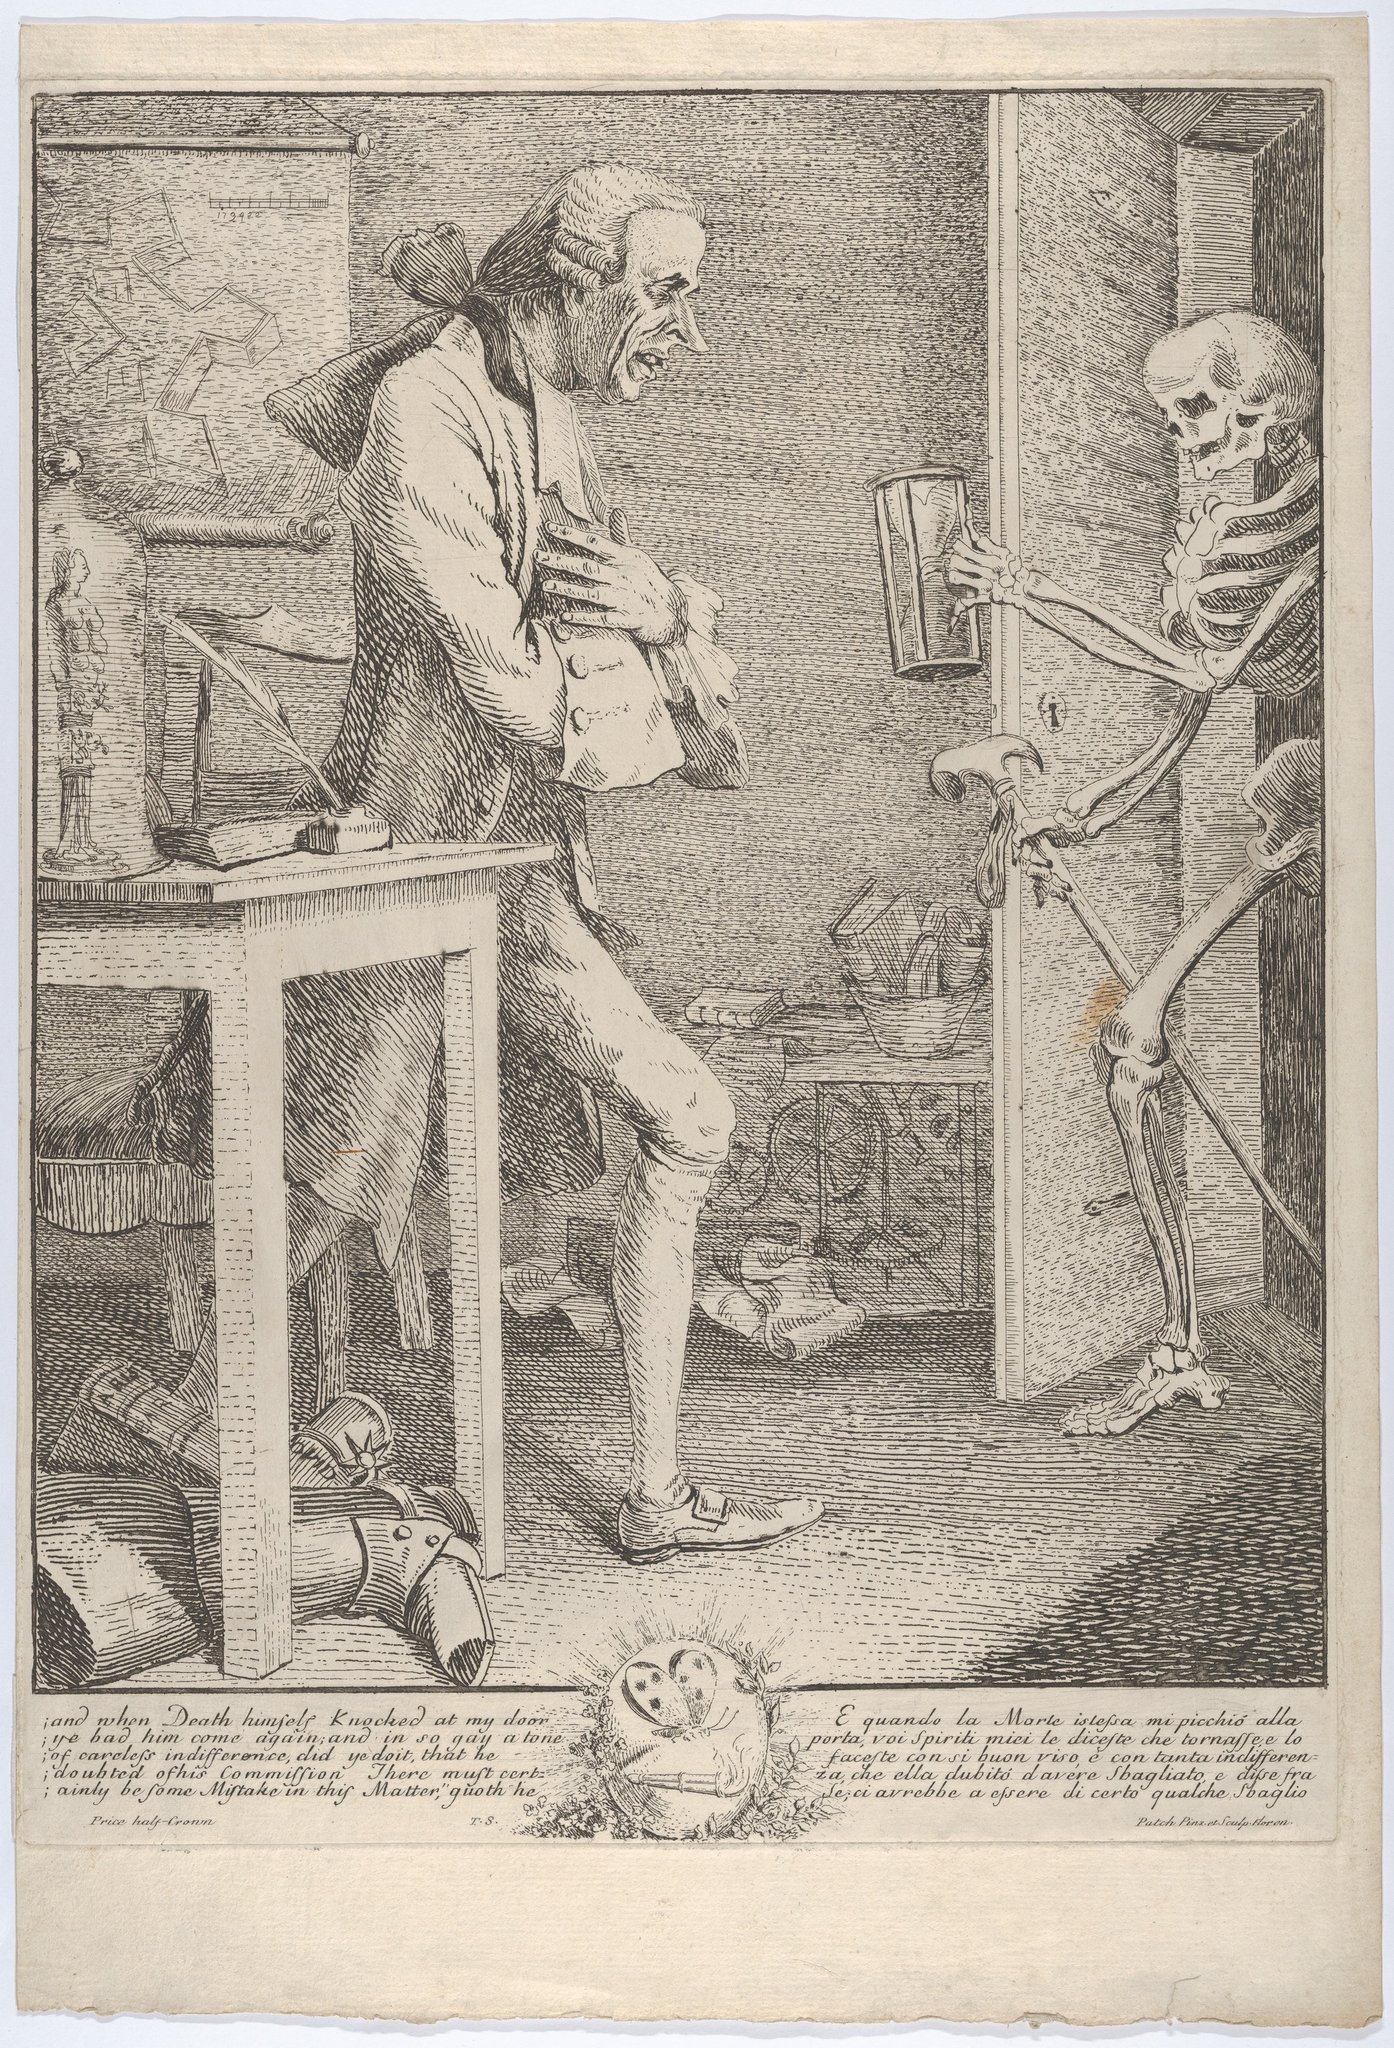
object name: print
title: Sterne and Death: "And When Death Himself Knocked at My Door"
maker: thomas patch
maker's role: artist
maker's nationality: british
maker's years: 1725-1782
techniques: etching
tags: skeletons,men,hourglass